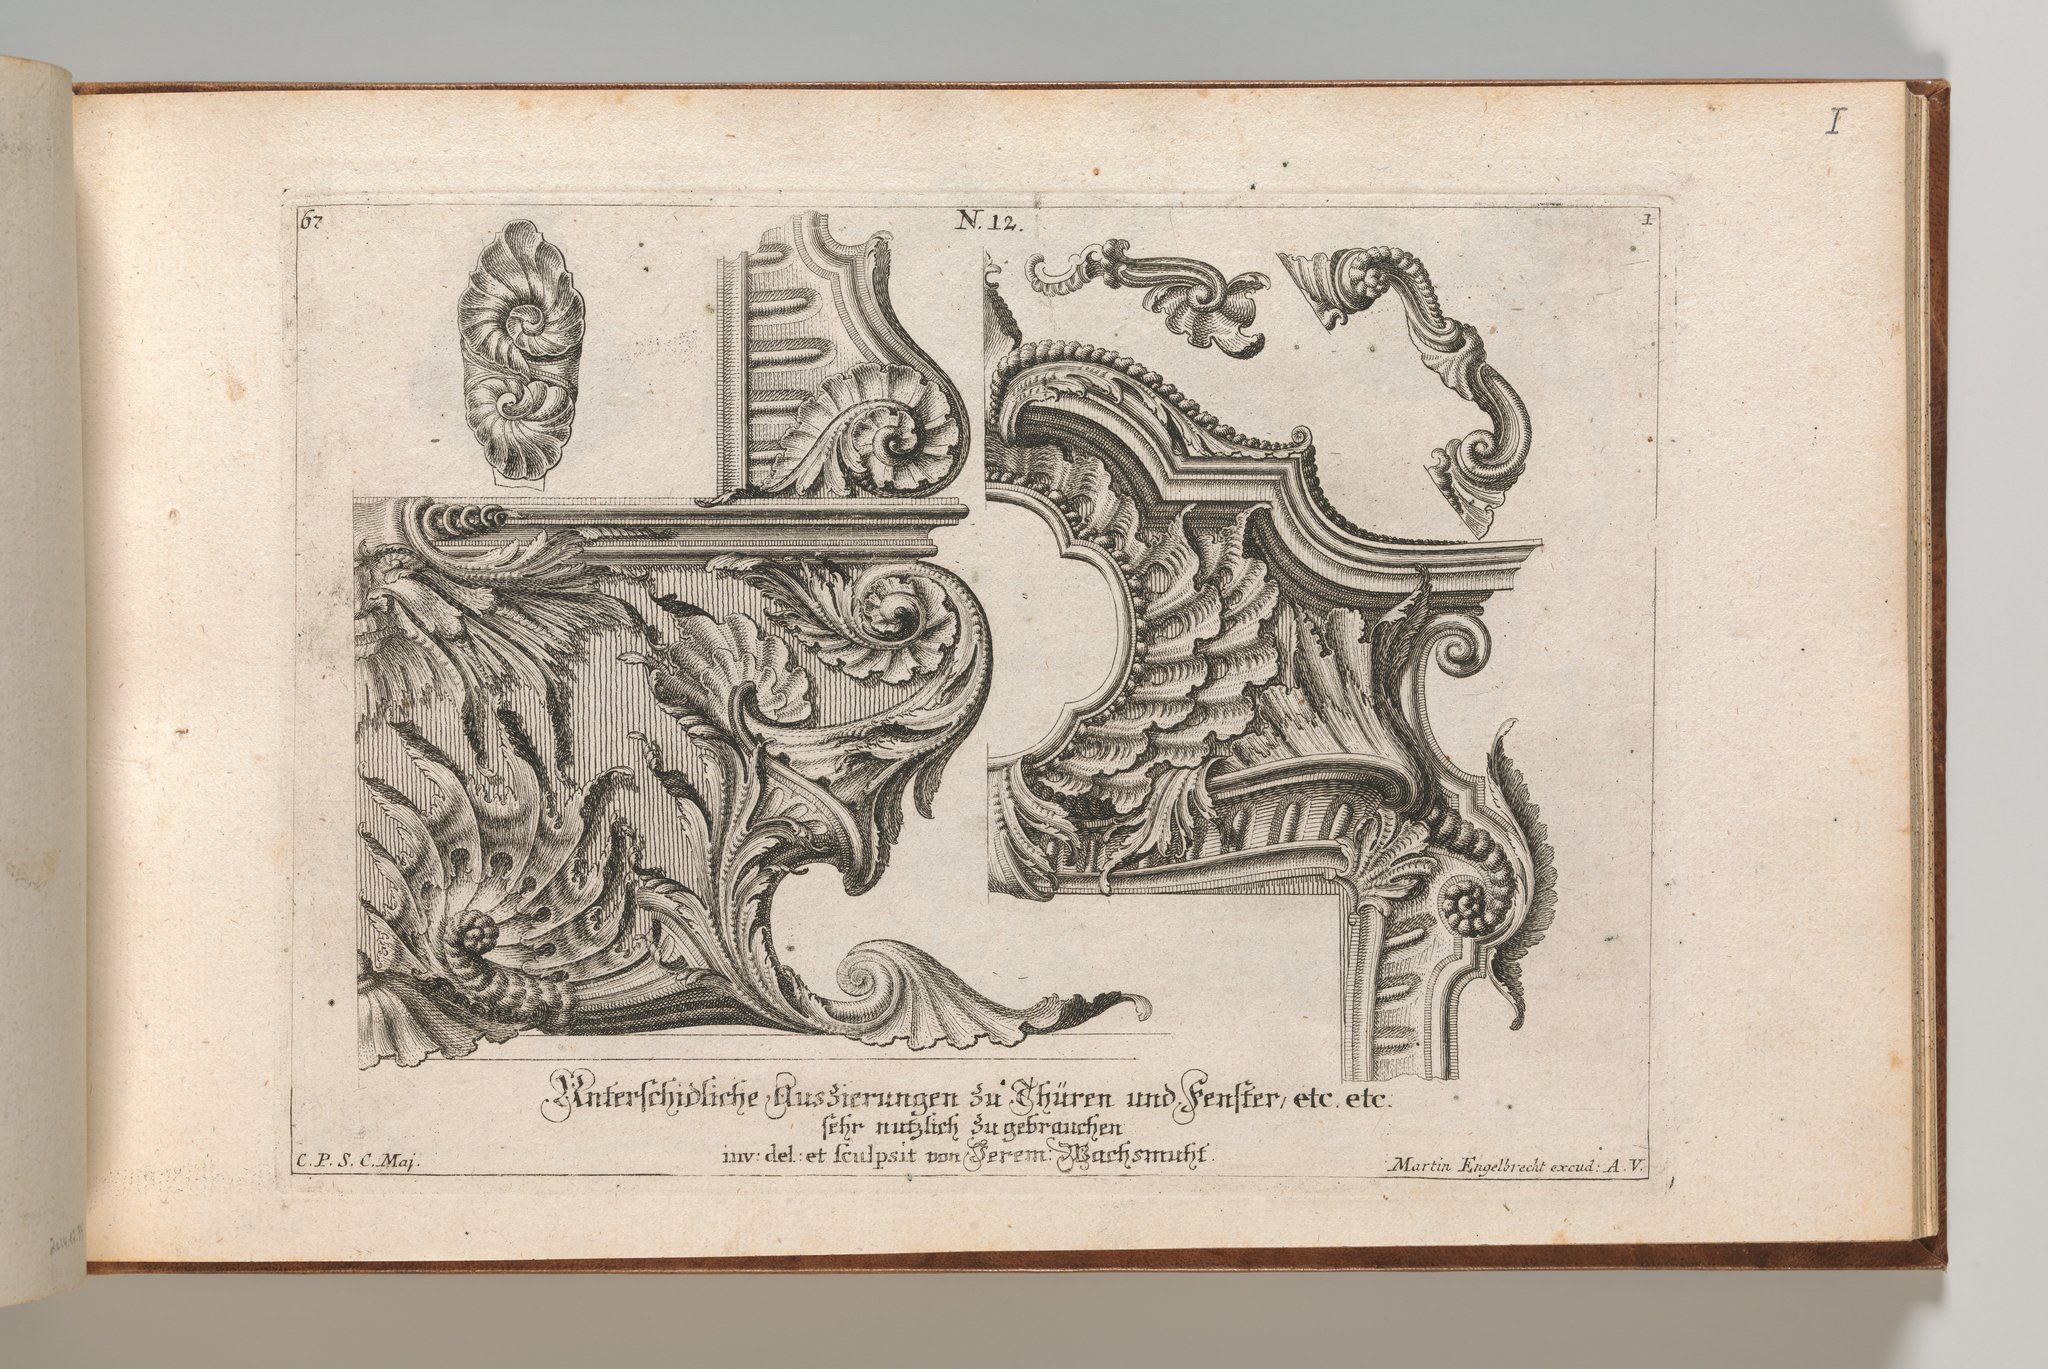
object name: album print ornament architecture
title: Suggestion for the Decoration of the Lower and Top Right of a Frame, Plate 1 from: 'Unterschidliche Auszierungen zu Thüren und Fenster, etc. etc. sehr nutzlich zu gebrauchen'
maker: jeremias wachsmuth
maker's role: artist and engraver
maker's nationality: german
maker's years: 1712-1771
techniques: etching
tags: ornament